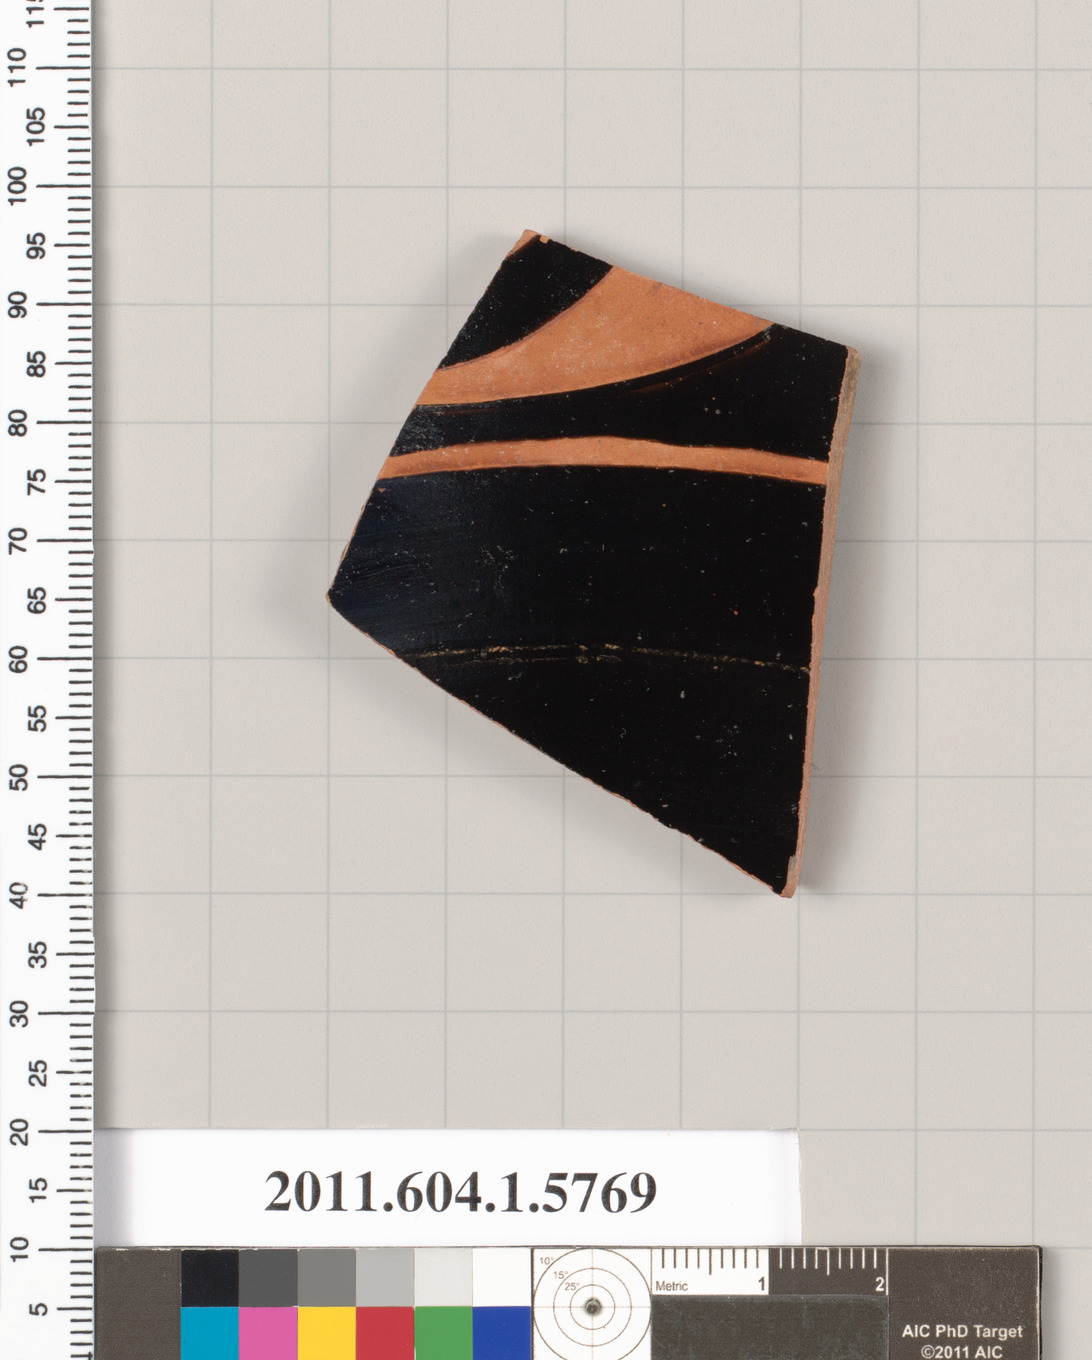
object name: kylix fragment, eye cup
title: Terracotta fragment of a kylix: eye-cup (drinking cup)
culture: greek, attic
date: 520-510 BCE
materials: terracotta